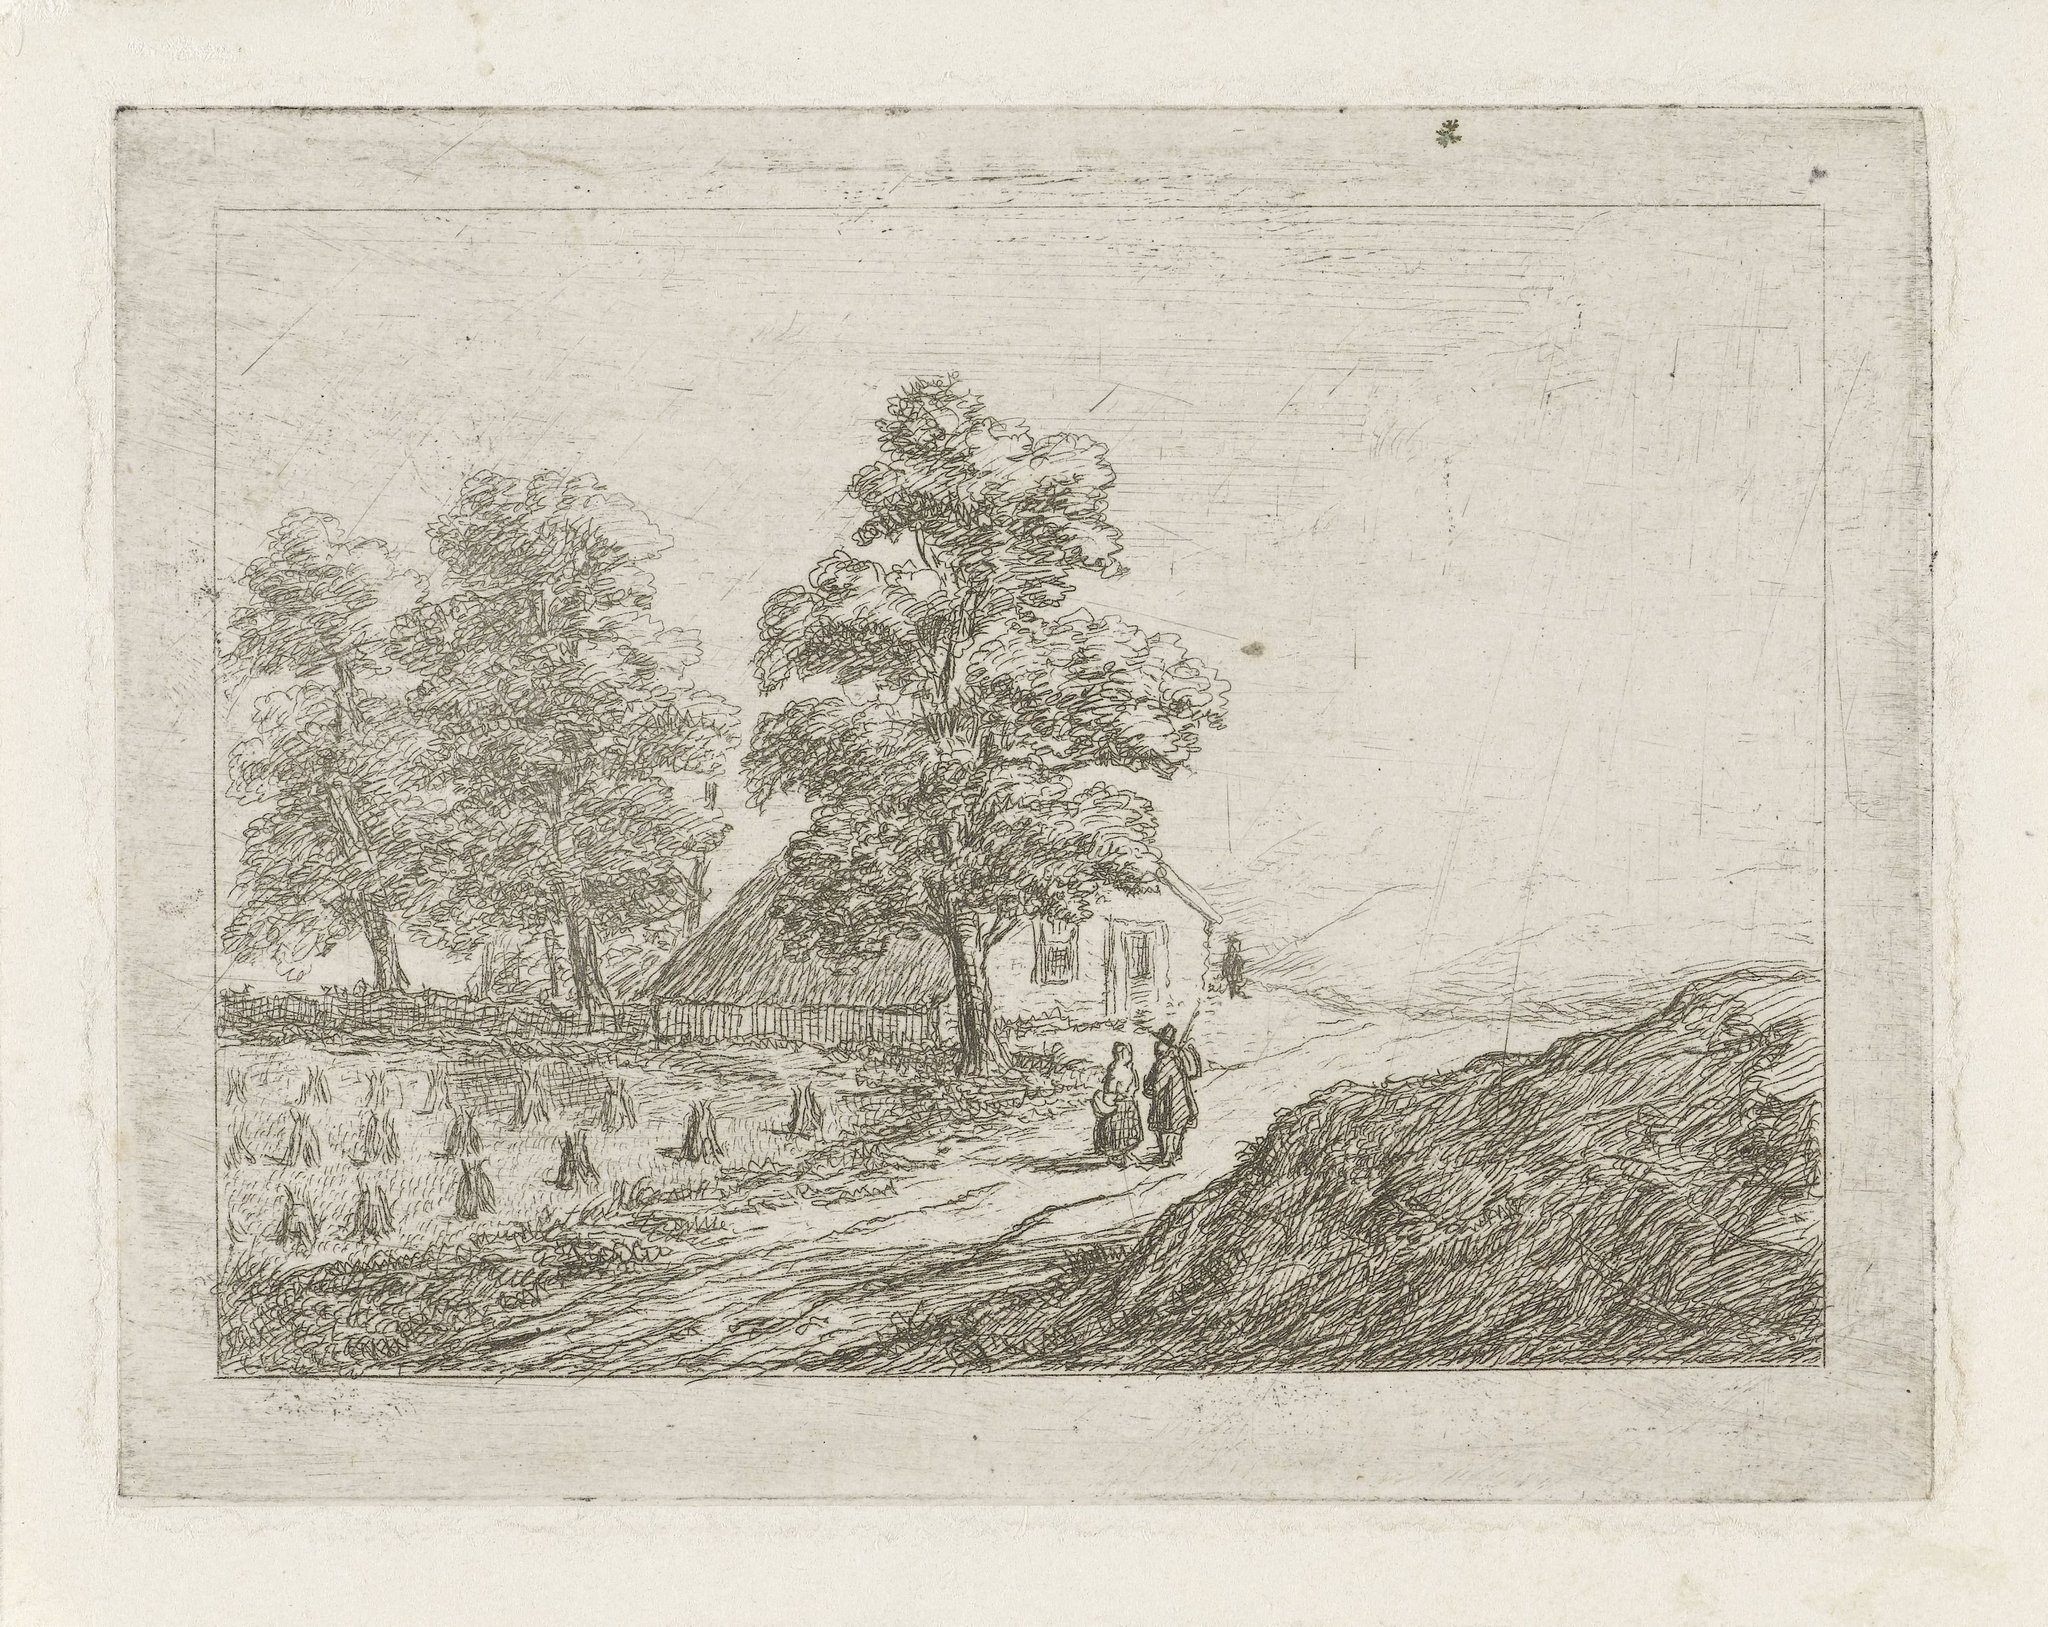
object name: print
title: Heuvelachtig landschap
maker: david van der kellen (1804-1879)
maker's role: die cutter, draughtsman, print maker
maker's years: 1804-1879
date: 1814-1859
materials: paper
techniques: etching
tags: farm or solitary house in landscape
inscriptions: collector's mark: Lugt 2228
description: Een heuvelachtig landschap met in het midden een weg met drie wandelaars. Rechts van de weg ligt een veld met korenschoven een daarachter een boerenhoeve.